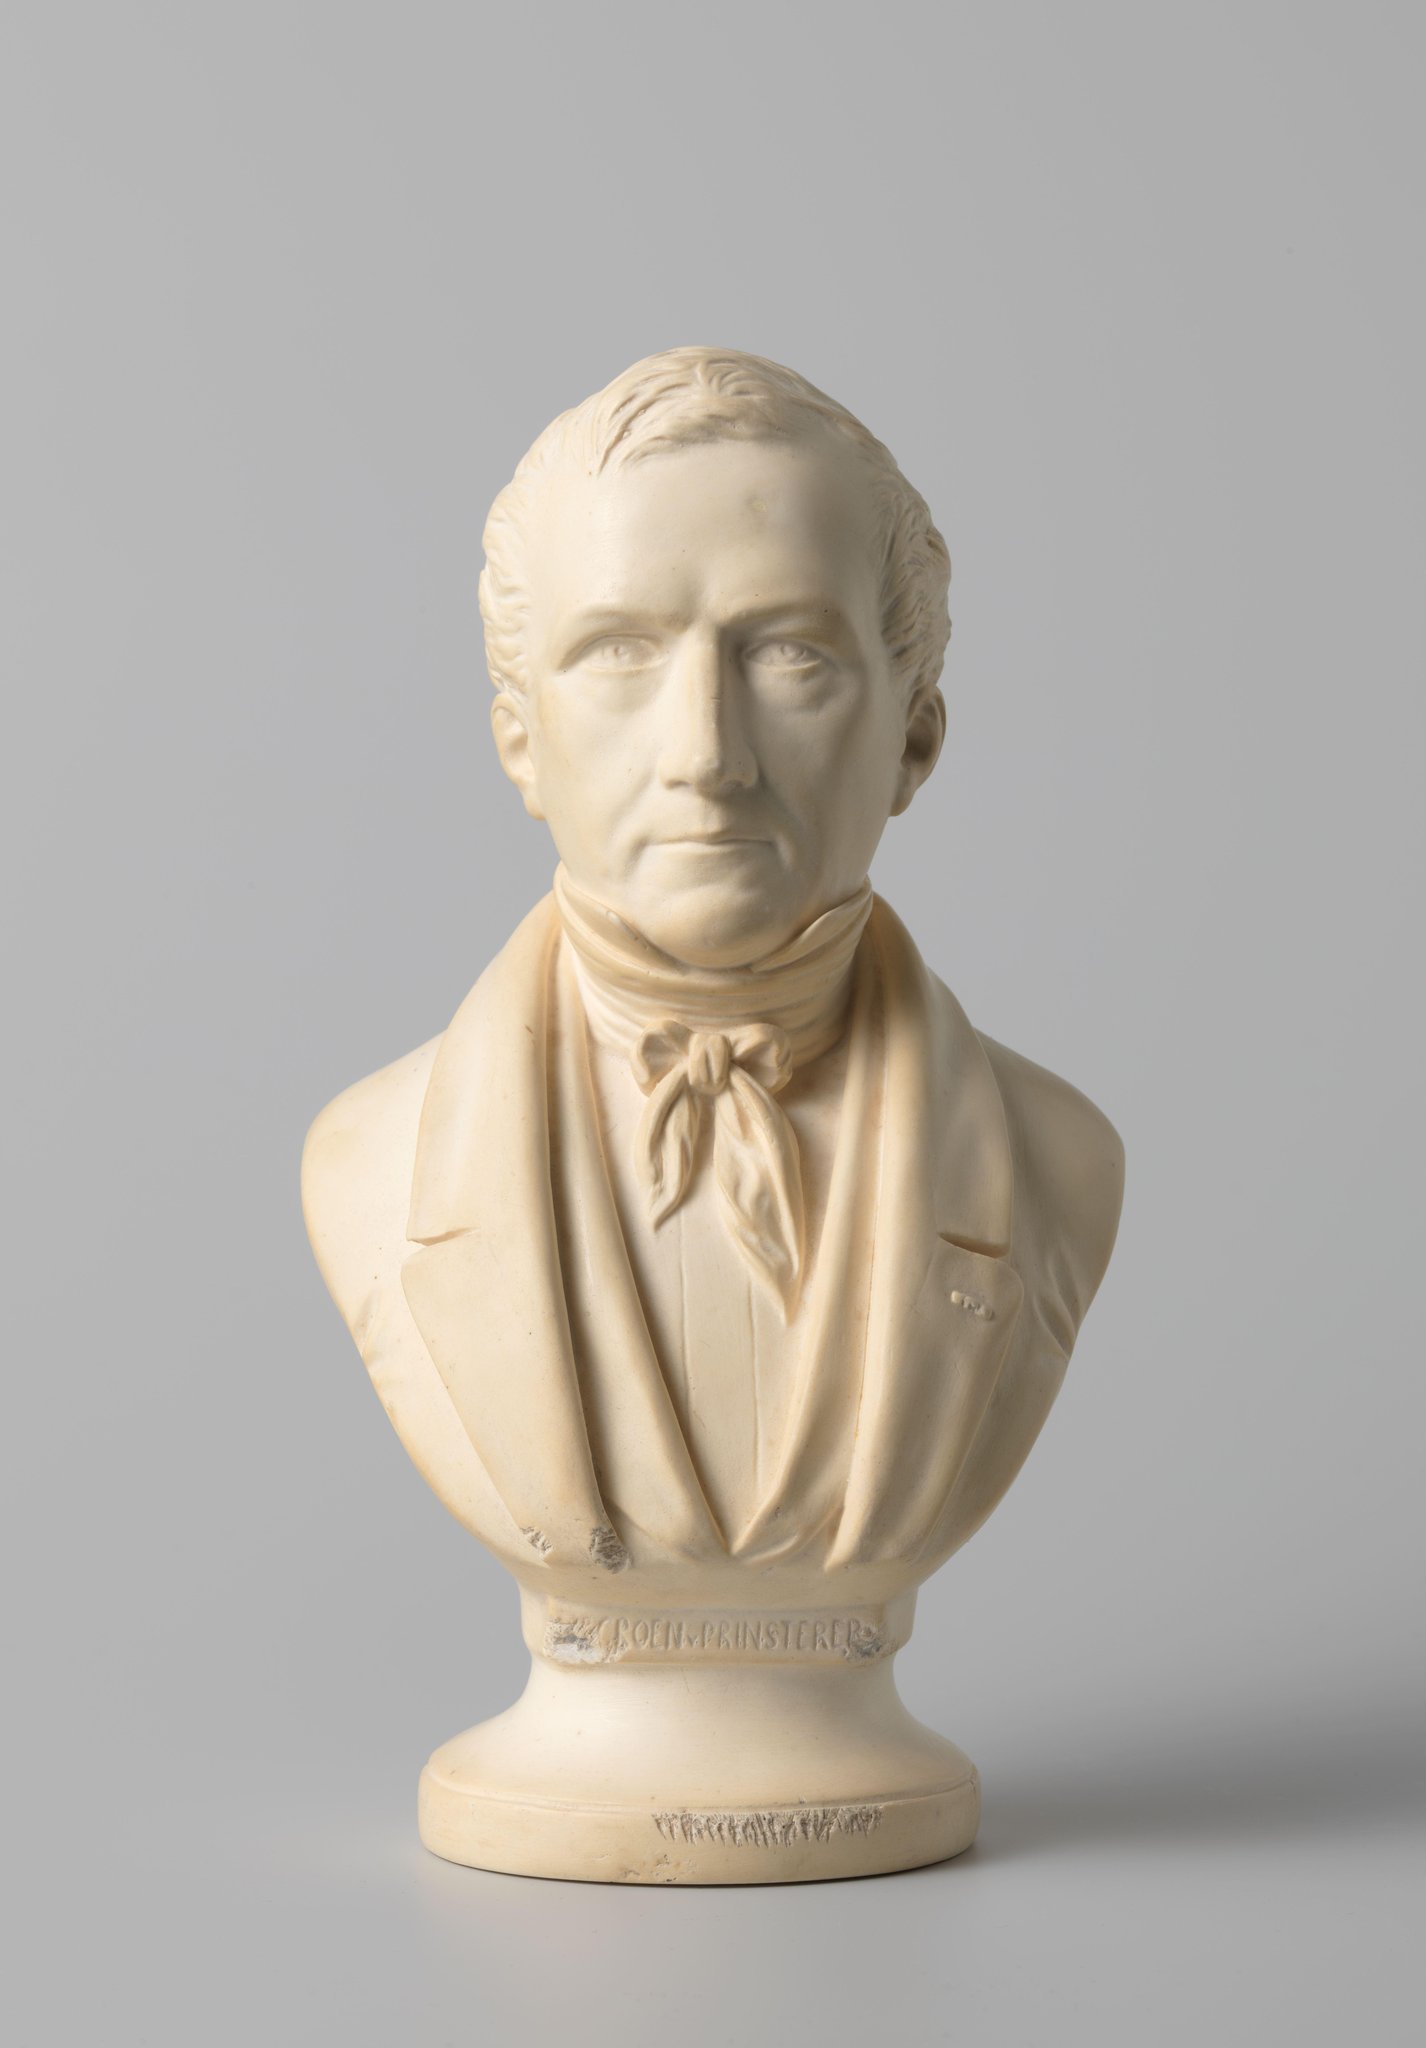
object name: sculpture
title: Borstbeeld van Guillaume Groen van Prinsterer (1801-1876)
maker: theo simons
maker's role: sculptor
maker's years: 1842-1909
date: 1876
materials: gypsum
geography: netherlands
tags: guillaume groen van prinsterer, netherlands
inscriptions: signature and date: ‘Theo C. Simons 1876’, inscription: ‘Groen v. Prinsterer’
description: Guillaume Groen van Prinsterer (1801 - 1876), statesman and historian. Plaster. Th. C. Simons, 1876. Groen van Prinsterer is seen by some as the spiritual father of the Christian-historical or anti-revolutionary movement in Dutch politics. He believed that through its history Holland had become a Protestant nation, moulded by the struggle of Protestants in the 16th and17th centuries against the Catholic king of Spain. He rejected the godless principles of the French Revolution which had made man and not God the centre. Groen van Prinsterer entered parliament in1840, the same year as Thorbecke. He remained, with a short break, until 1866. The plaster bust was presented in 1886 by Queen Emma to the Rijksmuseum, newly opened in 1885.